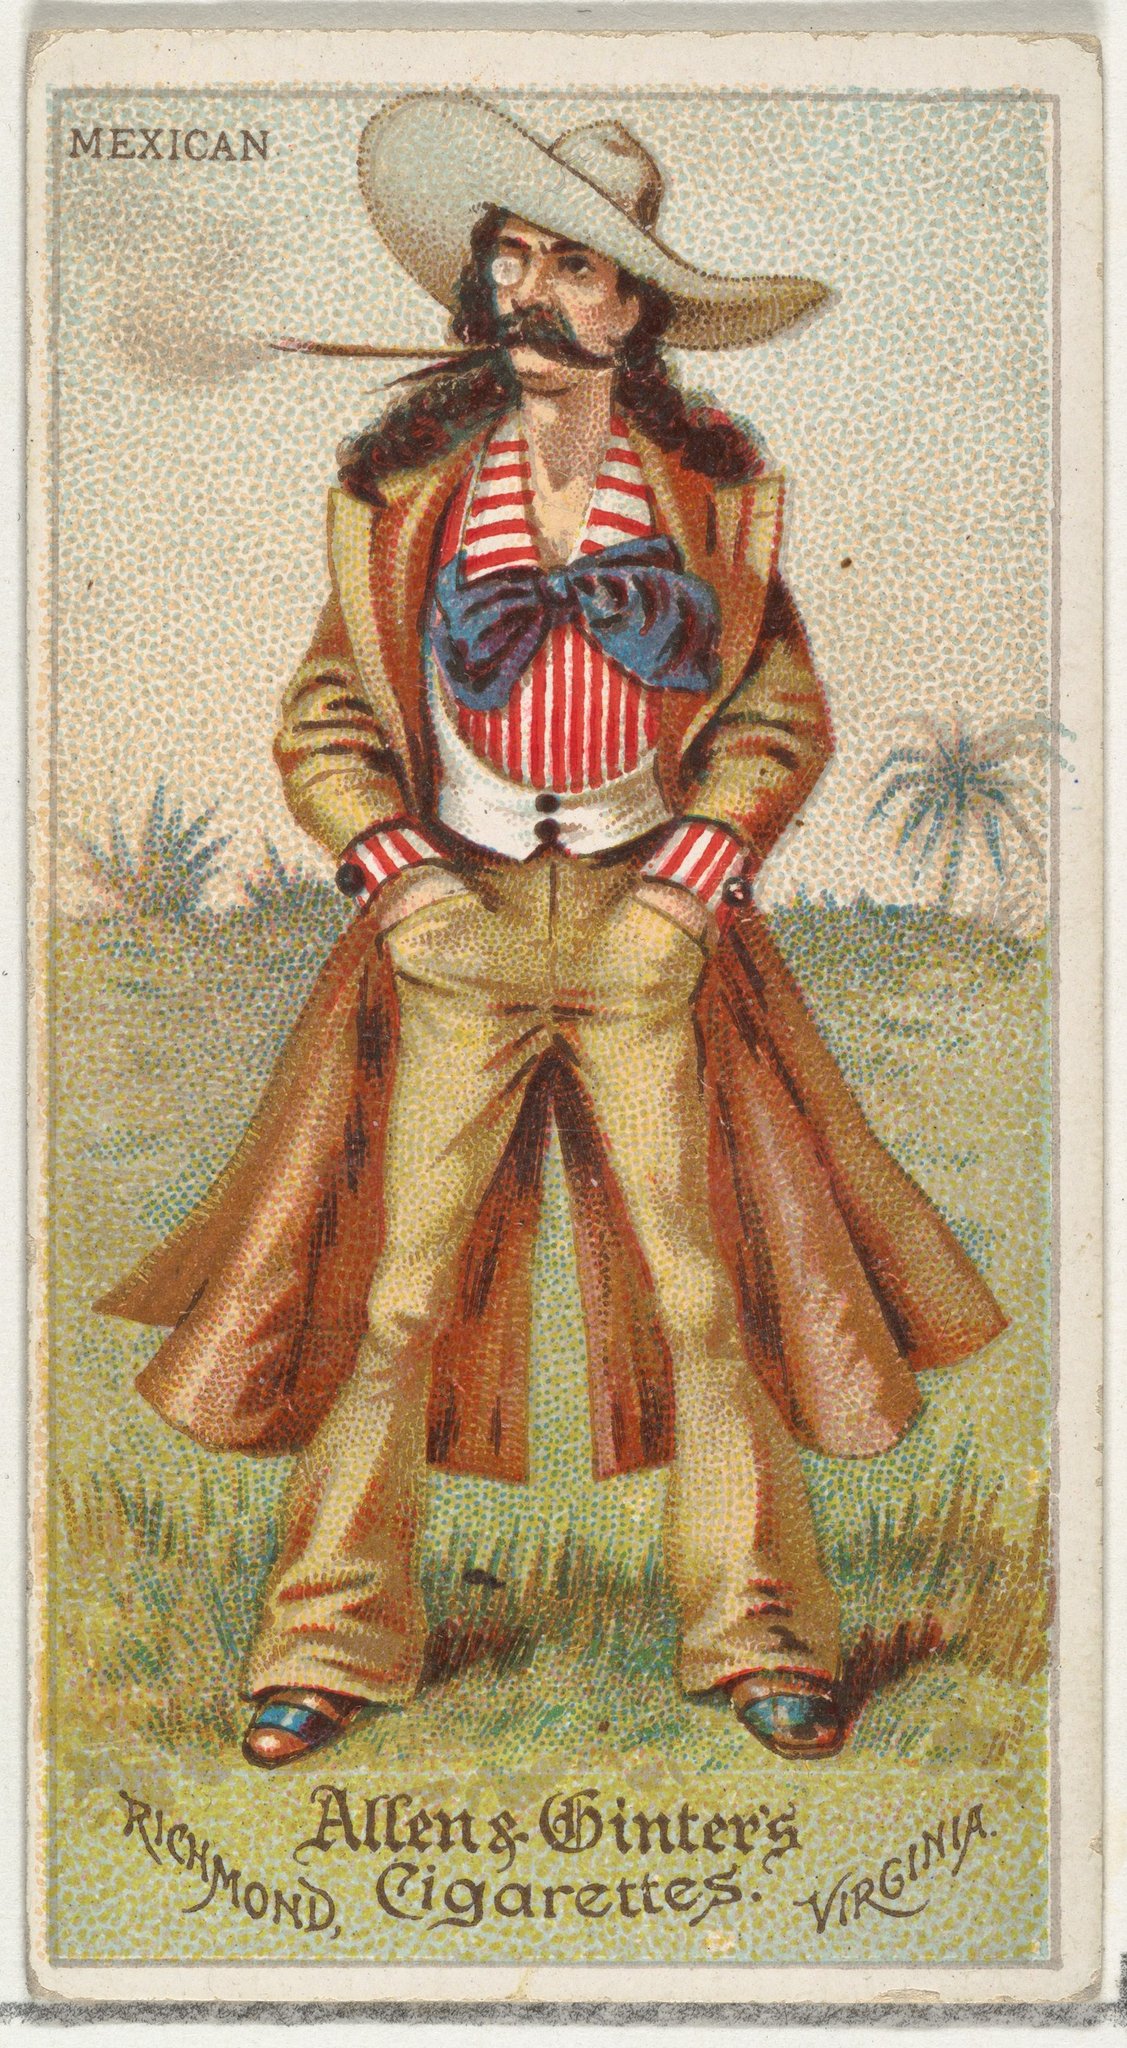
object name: print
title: Mexican, from World's Dudes series (N31) for Allen & Ginter Cigarettes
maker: allen & ginter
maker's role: publisher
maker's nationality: american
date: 1888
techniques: color lithograph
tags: men